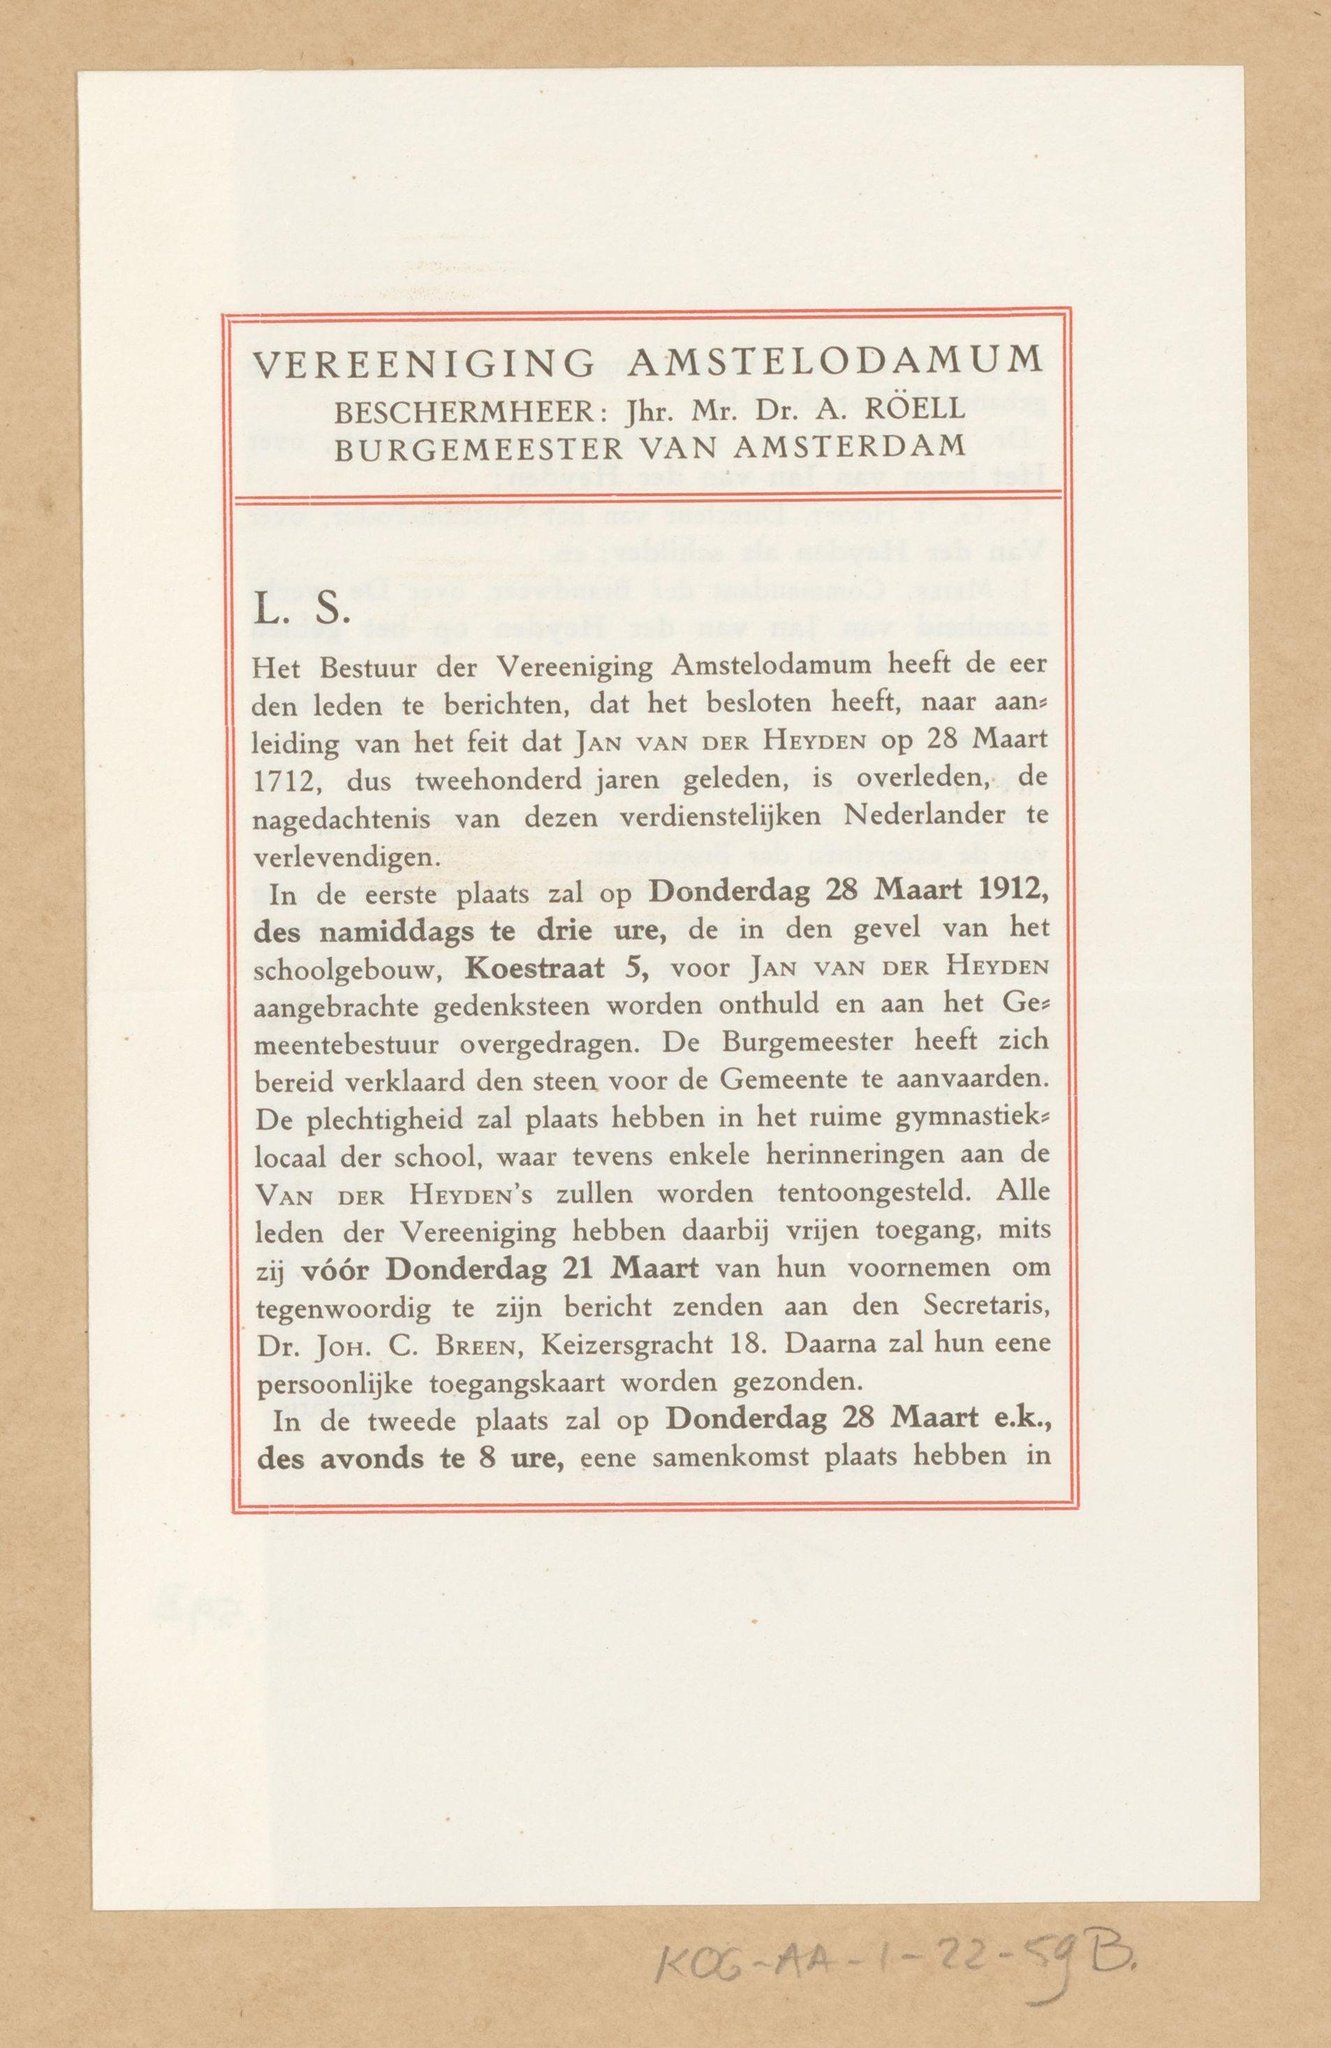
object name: text sheet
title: Bekendmaking van activiteiten naar aanleiding van het tweehonderdste overlijdensjaar van Jan van der Heyden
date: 1912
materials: paper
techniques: letterpress printing, printing block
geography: amsterdam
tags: amsterdam, print maker, draughtsman, jan van der heyden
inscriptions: collector's mark: Lugt 1641b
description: Onderwerpsrubriek binnen de Atlas Amsterdam: Gemeentewerken: A. Brandweer.